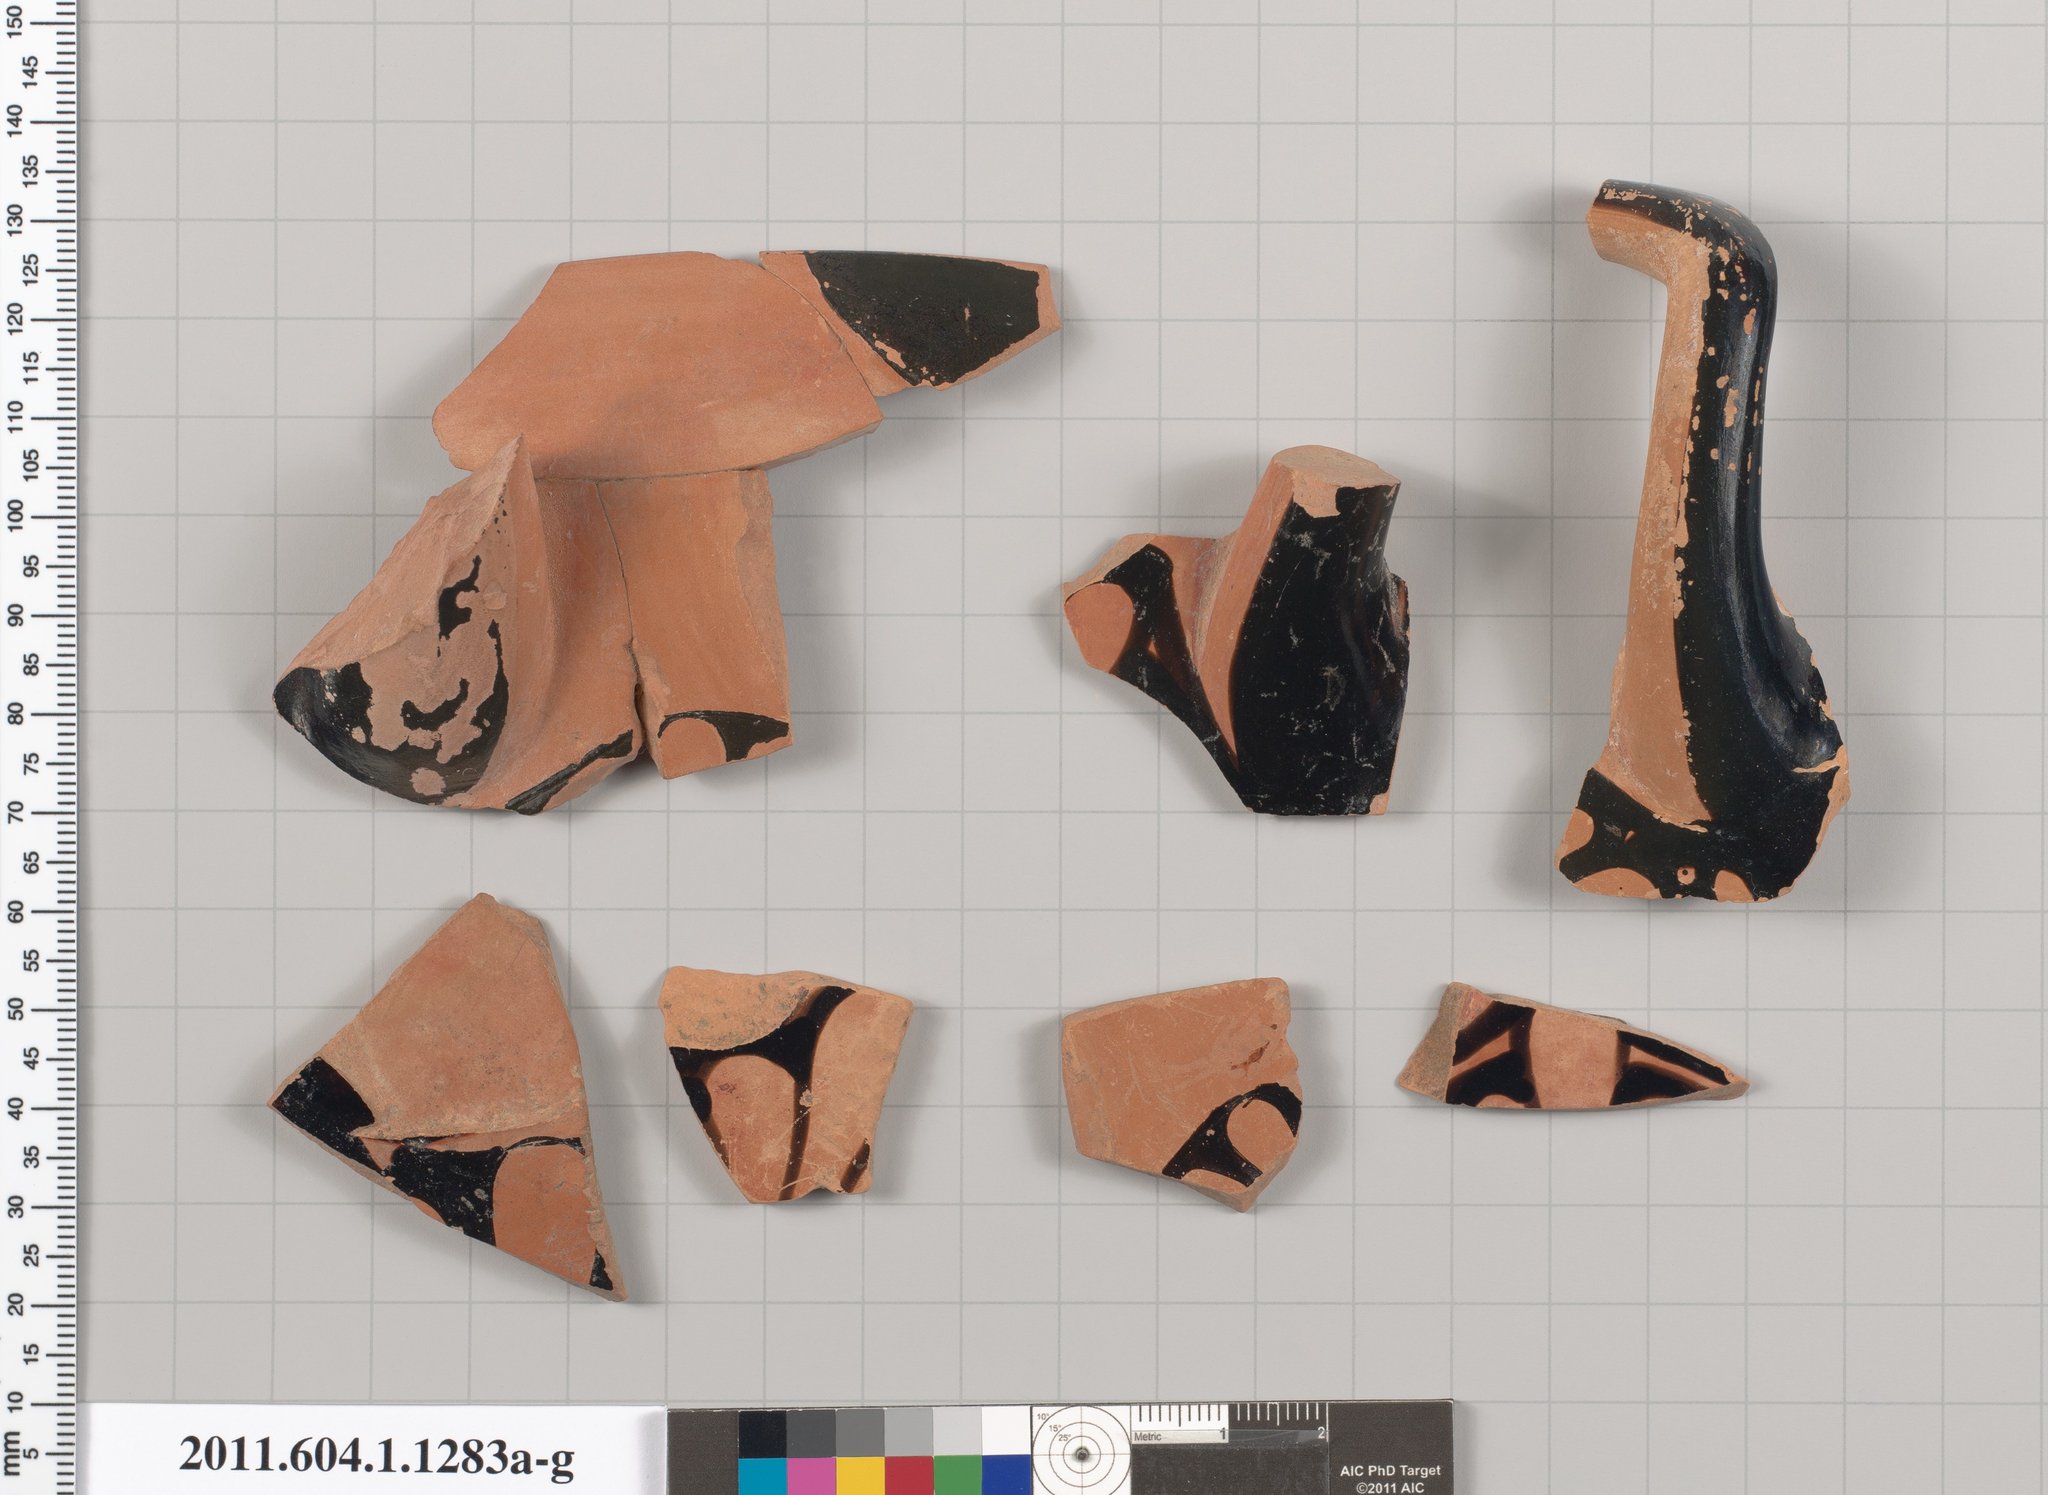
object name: kylix fragment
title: Terracotta fragments of kylikes (drinking cups)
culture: greek, attic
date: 534-468 BCE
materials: terracotta